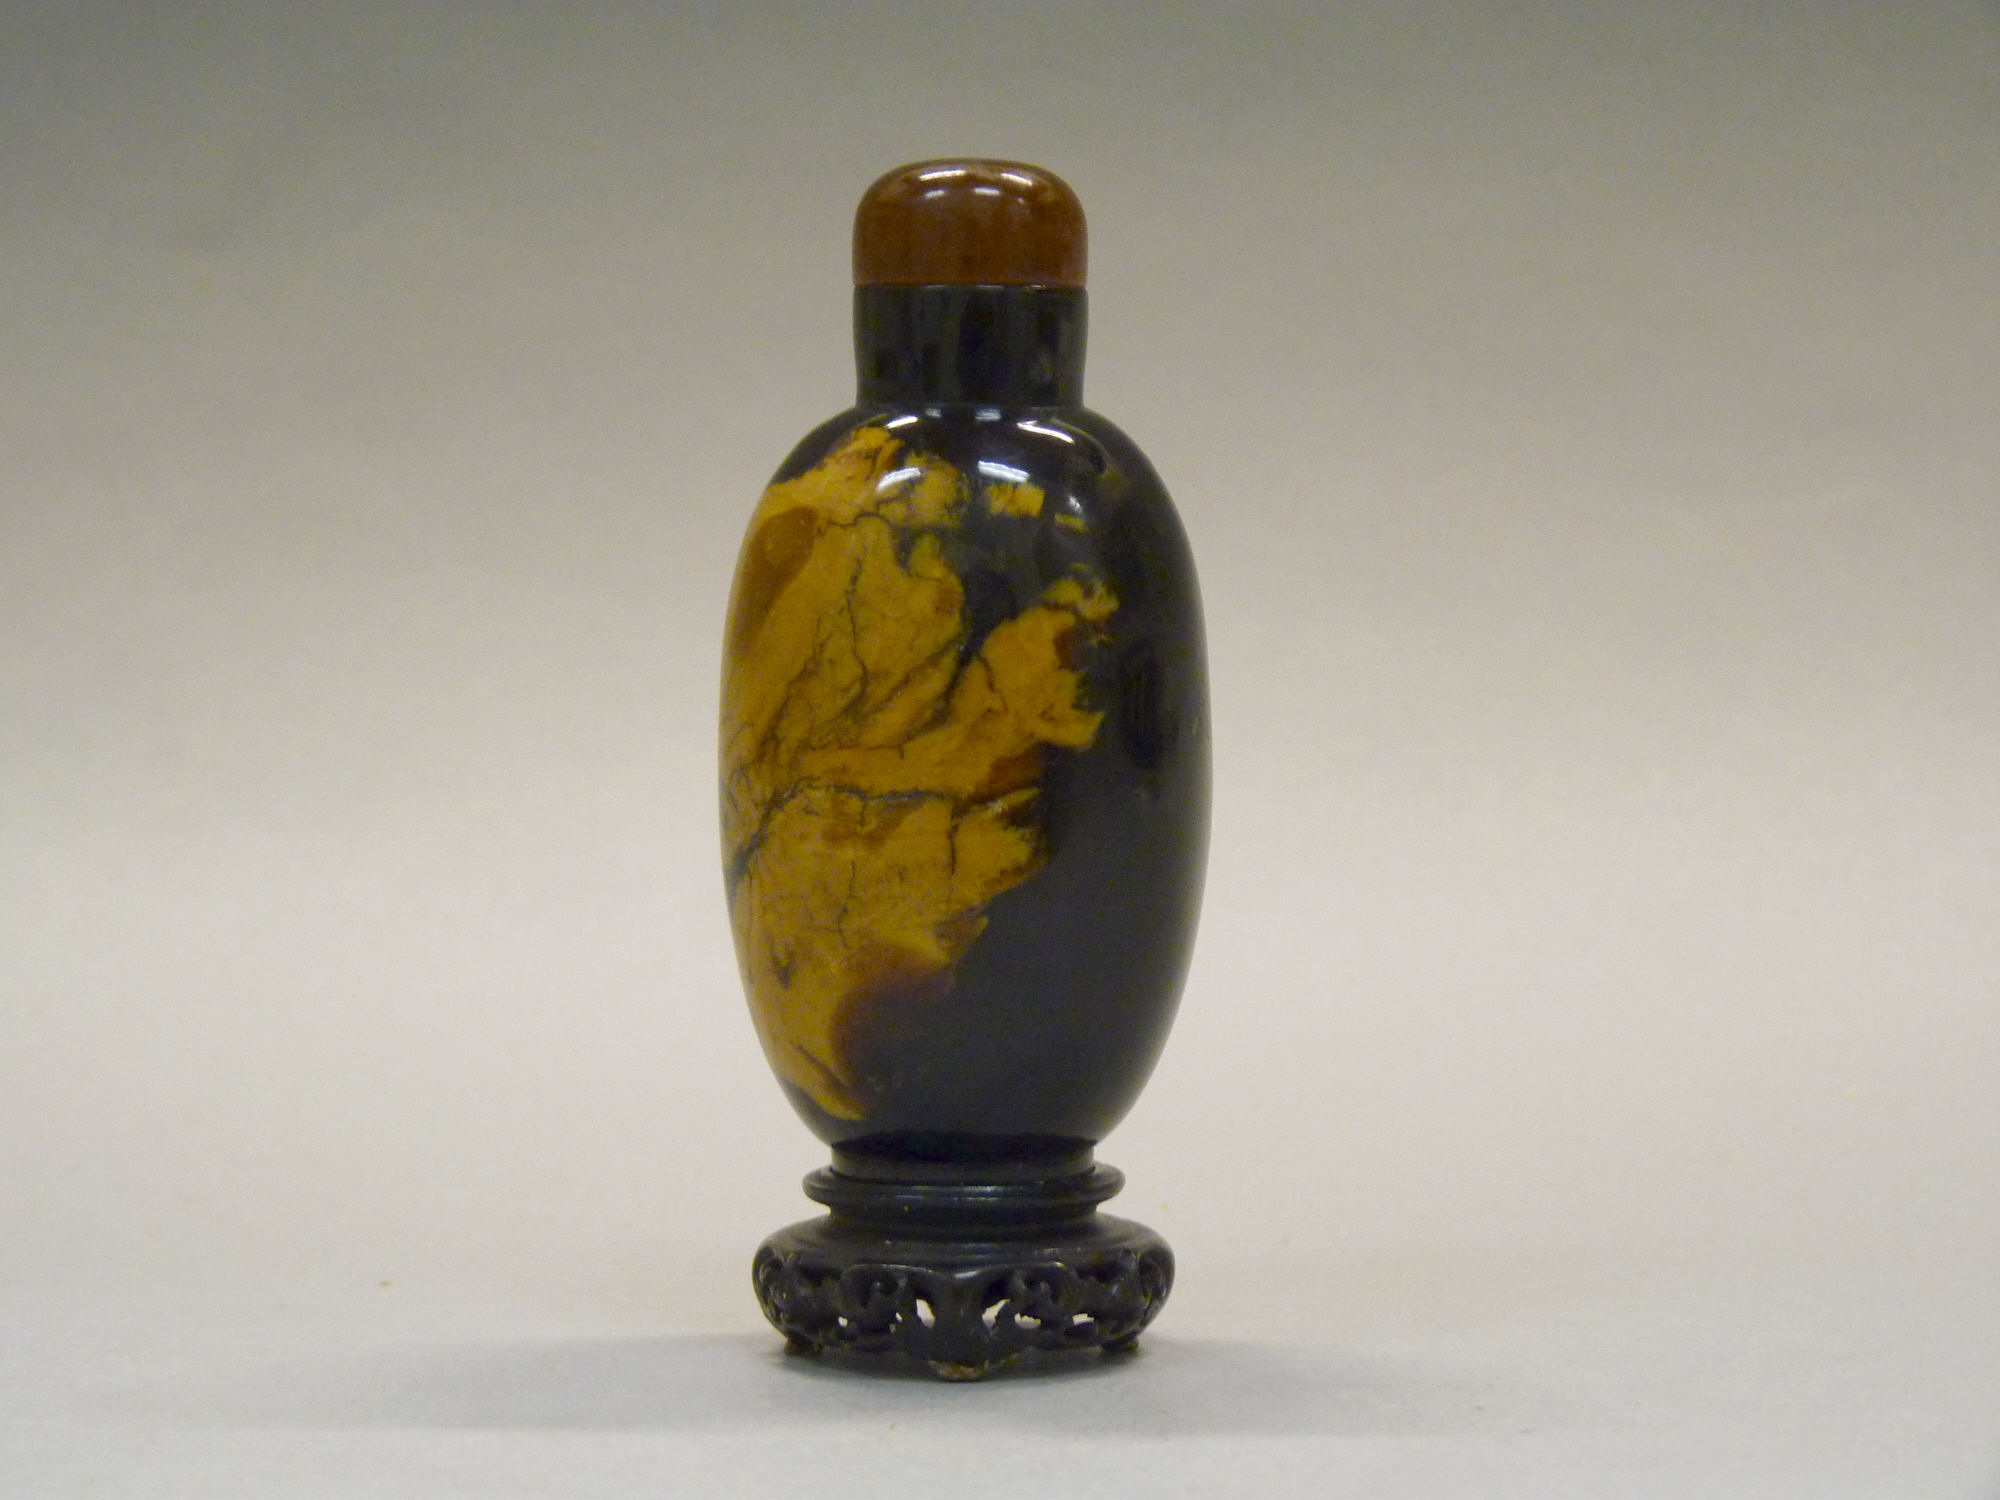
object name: snuff bottle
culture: chinese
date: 1801-1900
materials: amber